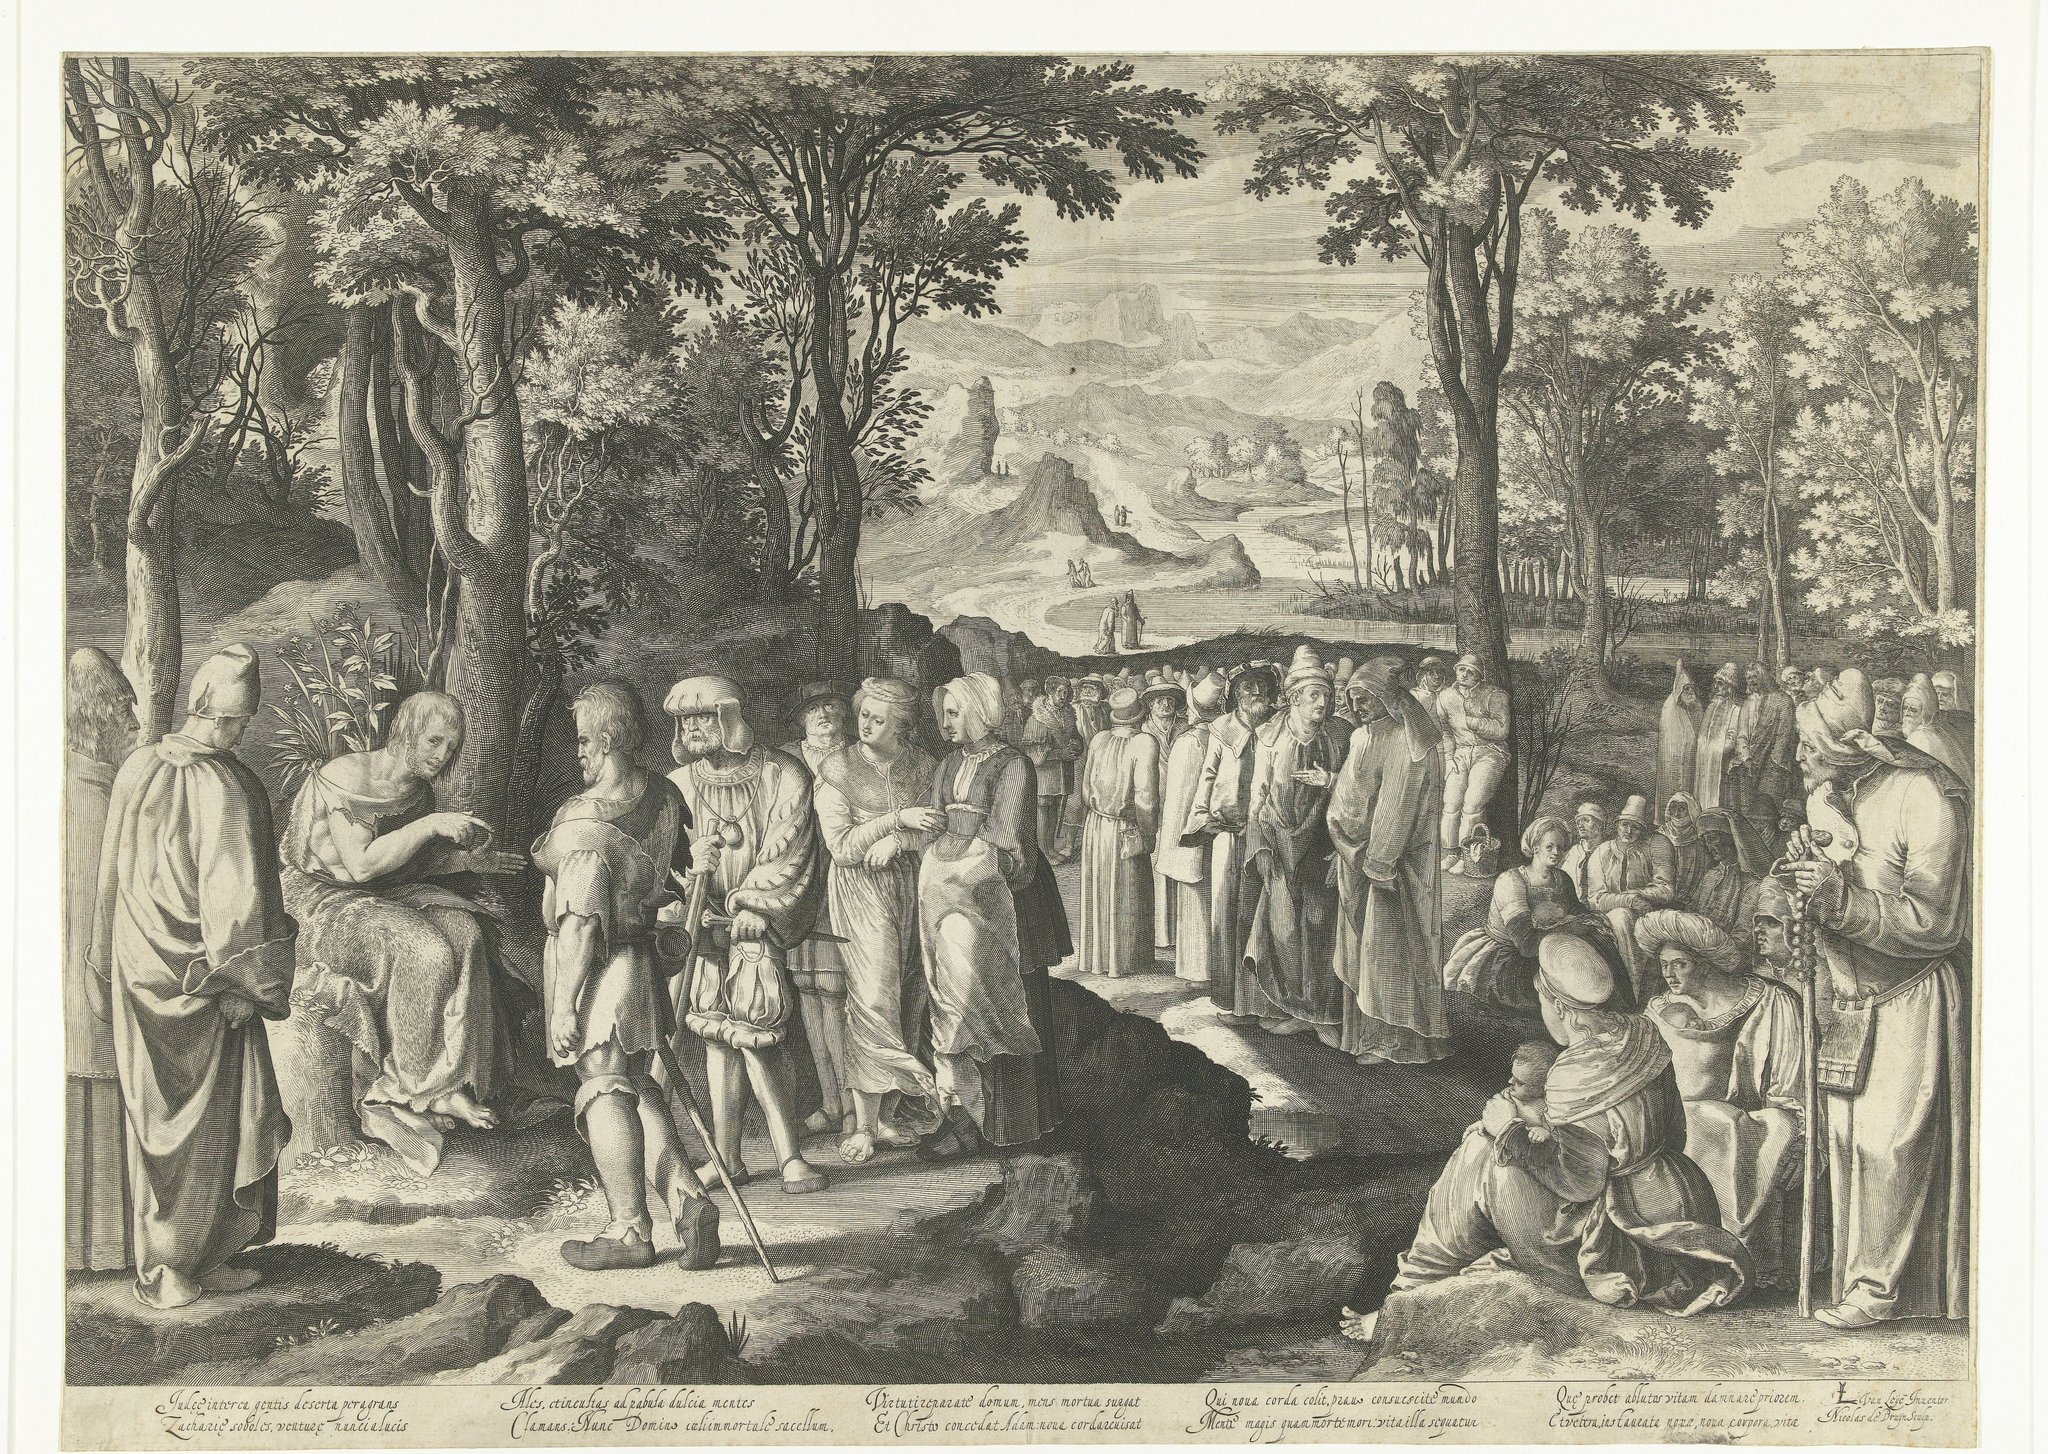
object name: print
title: Johannes de Doper predikt tot de menigte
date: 1581-1656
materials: paper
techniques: engraving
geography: netherlands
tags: john the baptist preaching (perhaps christ among the bystanders)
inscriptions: collector's mark: Lugt 2228, collector's mark: Lugt 240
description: Johannes de Doper zit op een rots voor een menigte. Gekleed in zijn kamelenhuid predikt hij voor zijn toehoorders in een boomrijk landschap met een bergen en rivier op de achtergrond. In de verzamelde groep bevinden zich moeders met kinderen, pelgrims, herders, geleerden en edelmannen. In de marge onder staat een vers in Latijn.